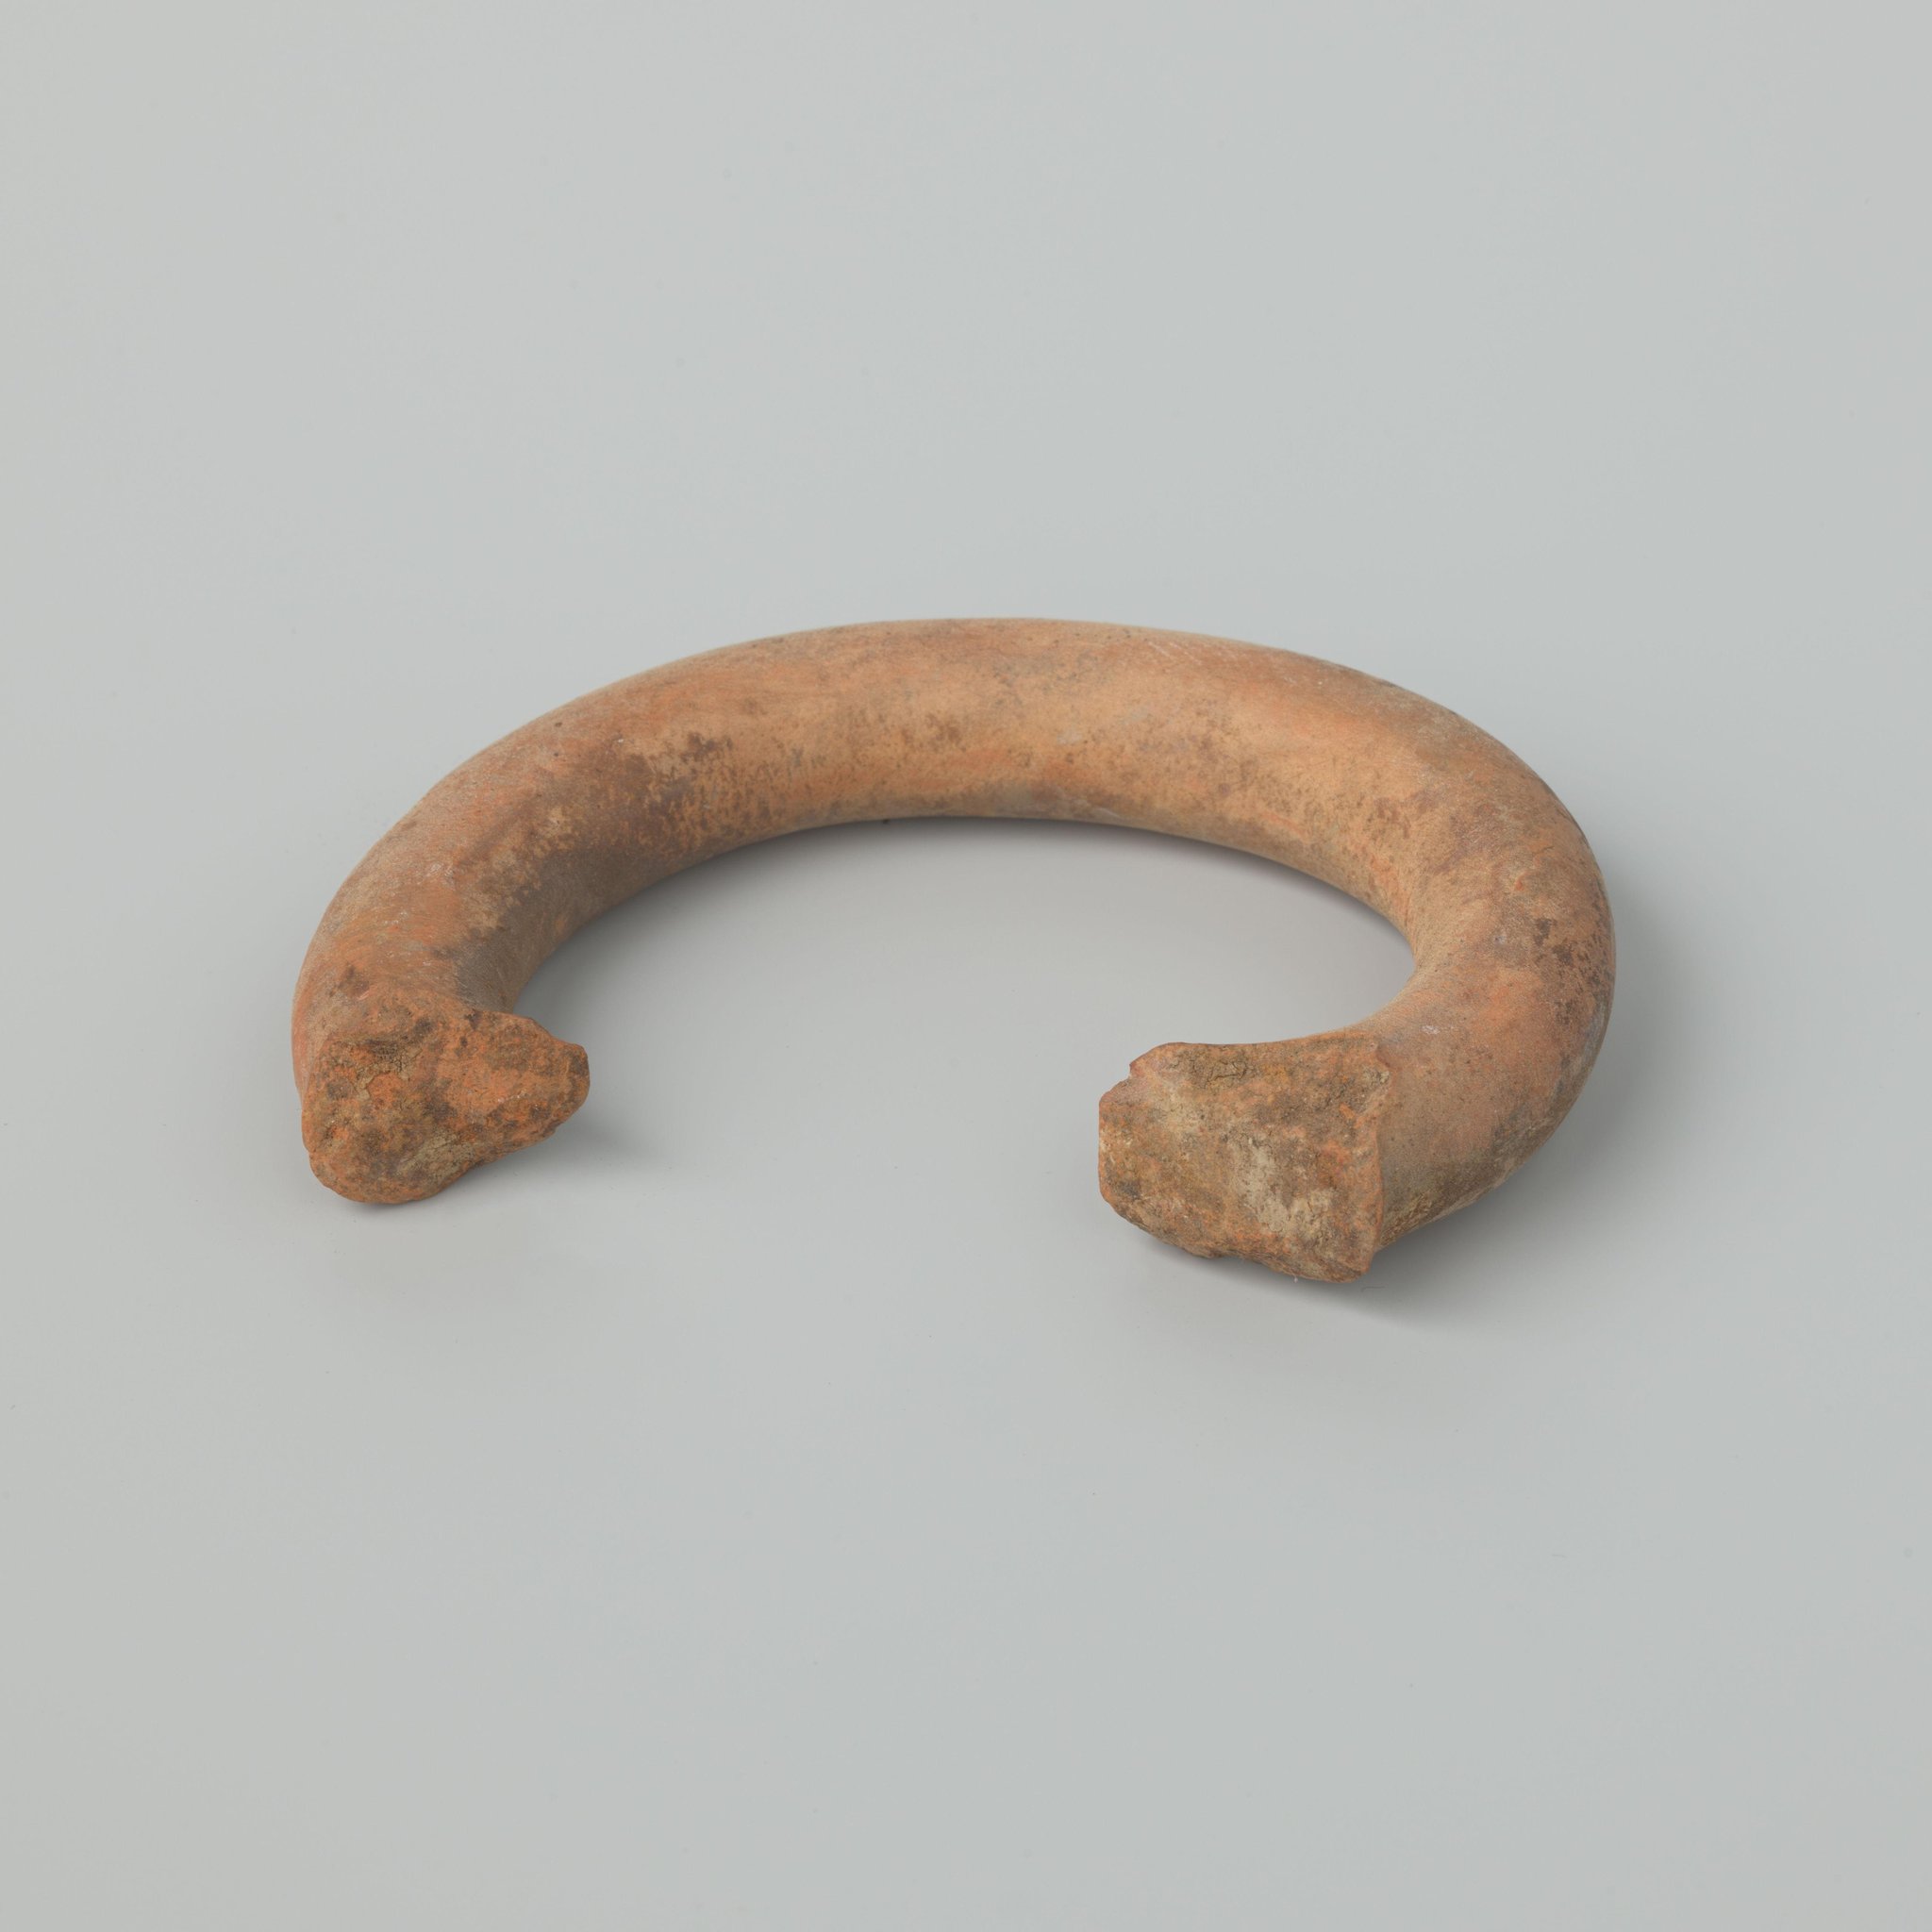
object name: lug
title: Oor van een theepot (De Caluwe bakafval)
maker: jacobus de caluwe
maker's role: plateelbakkerij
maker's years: -1730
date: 1700-1725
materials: earthenware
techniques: firing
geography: delft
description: Toegeschreven aan Jacobus de Caluwe, omdat dit voorwerp samen met gemerkte stukken (‘Jacobus De Caluwe’ en rennend hert) gevonden is op de plaats waar zich De Caluwes tweede werkplaats bevond. Er is een duidelijke stilistische overeenkomst tussen de gemerkte en niet gemerkte voorwerpen uit deze archeologische vondst.